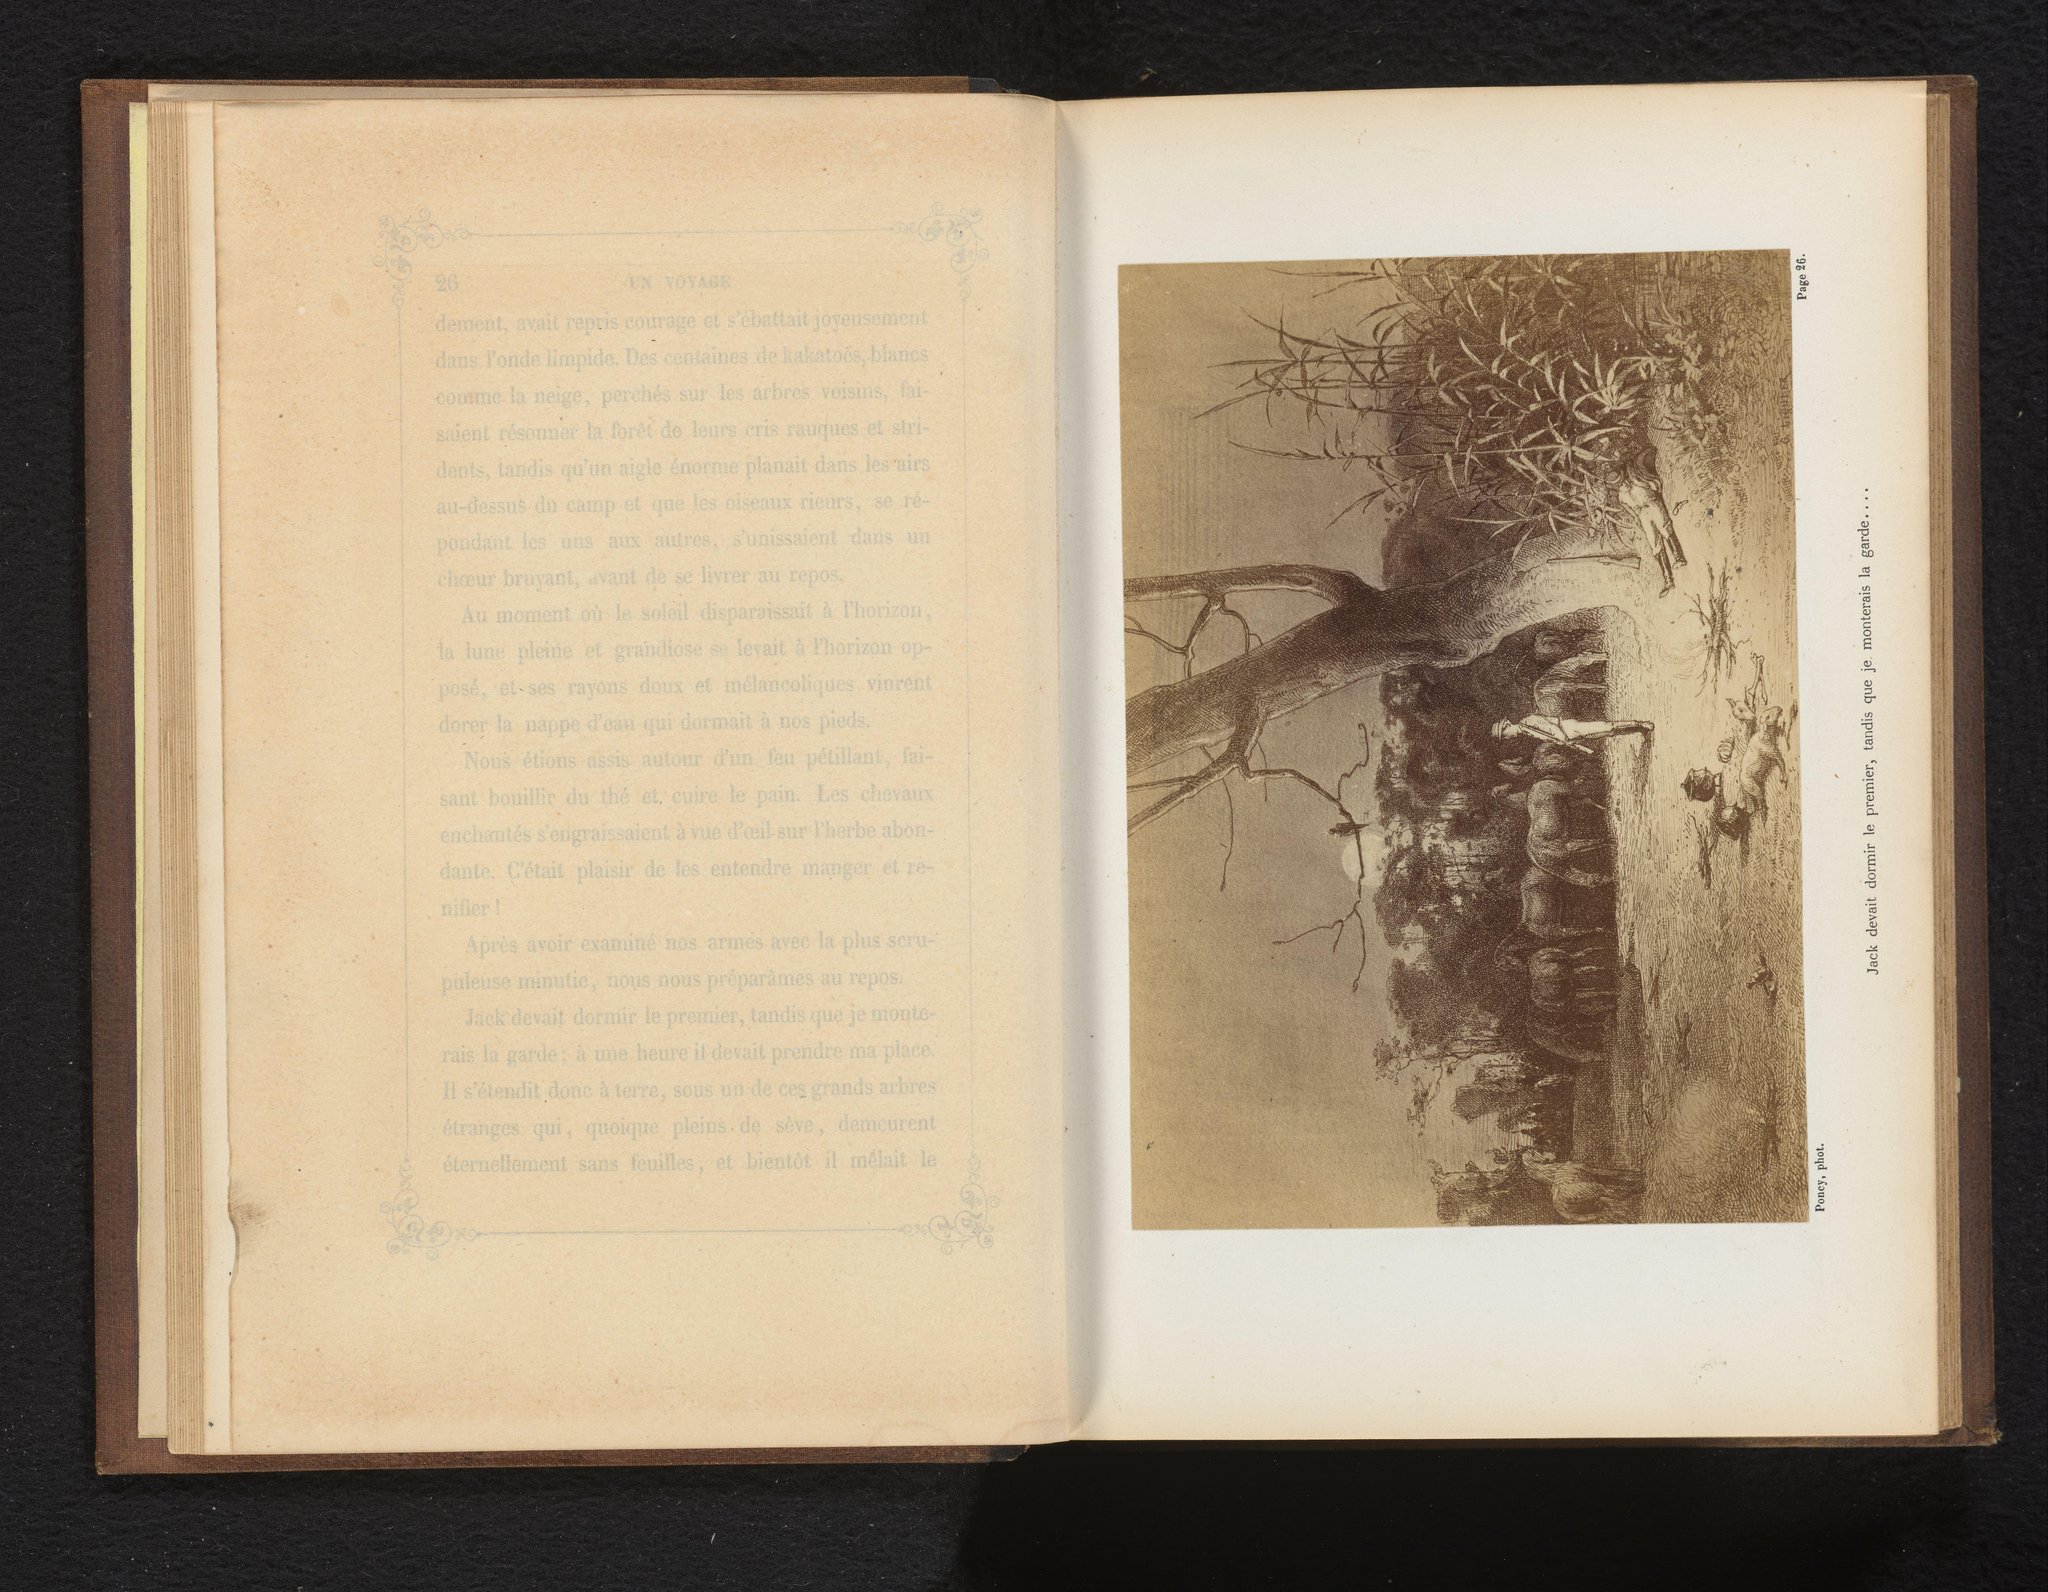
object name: page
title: Fotoreproductie van een tekening van een kamp in de Australische outback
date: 1863-1868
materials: paper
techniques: albumen print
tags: sleeping on the ground - bb - out of doors, camp-fire; watch-fire, australia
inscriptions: inscription: ‘Page 26.’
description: Foto op ongenummerde pagina na pagina 26.